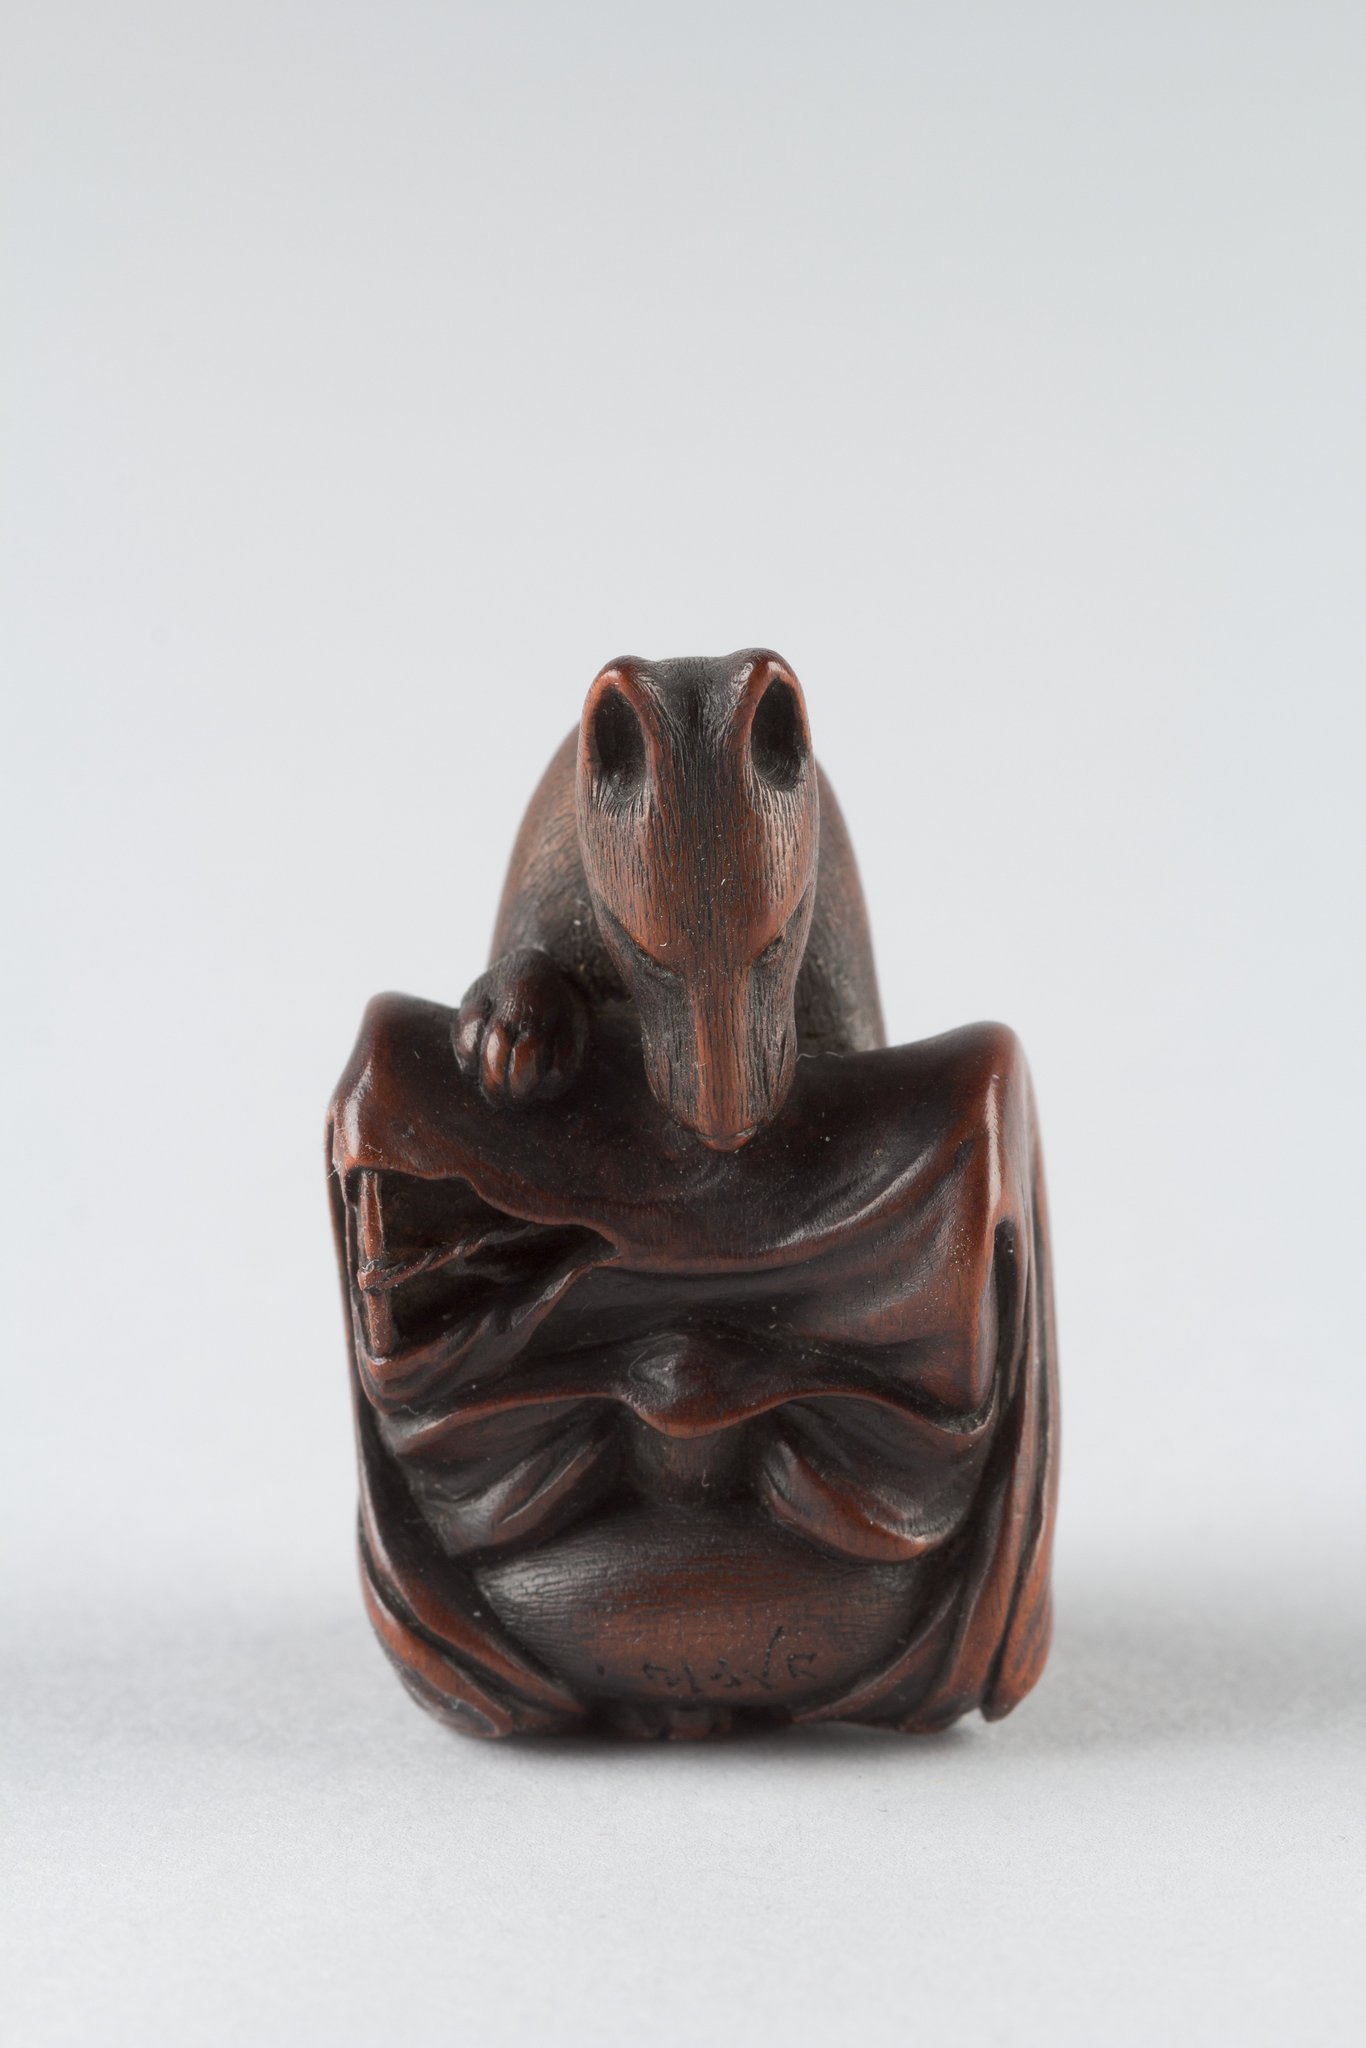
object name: netsuke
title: Netsuke with Fox and Drum from the Kabuki Play "Yoshsitsune Senbon-Zakura"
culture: japanese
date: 1801-1900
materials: wood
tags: foxes